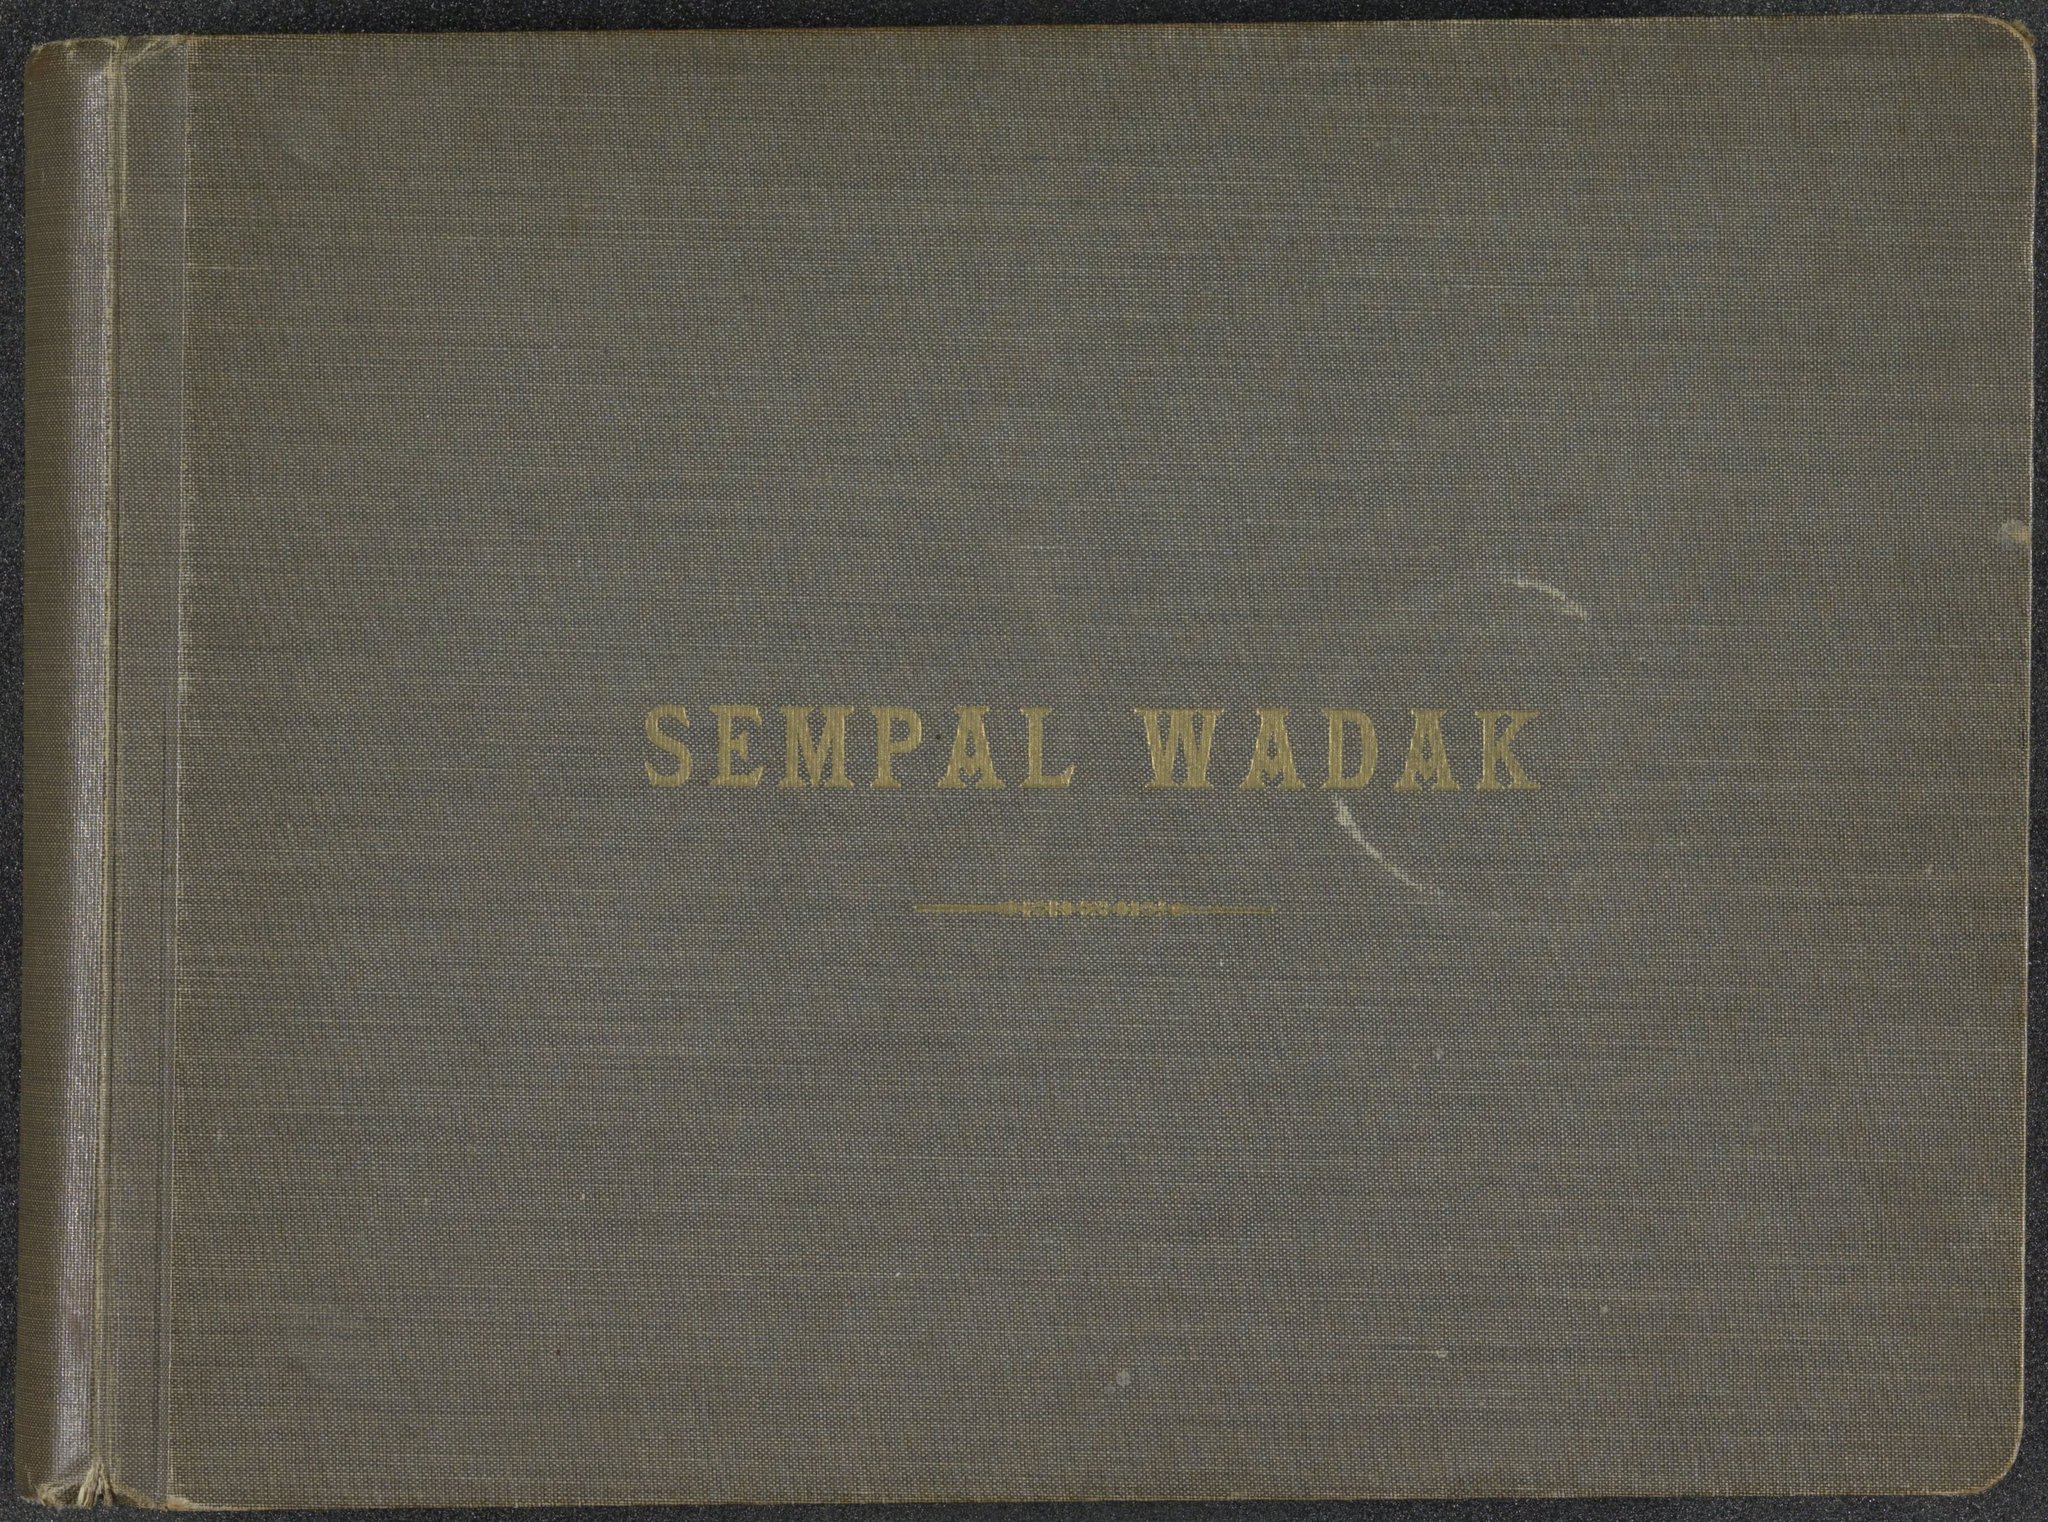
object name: scrapbook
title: Fotoalbum met opnames van de bouw van een brug over de Kali Brantas ten zuiden van Malang op Java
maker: Anonymous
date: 1890-1920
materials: cardboard, ink, linen, paper, photographic support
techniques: gelatin silver print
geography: dutch east indies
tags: engineering, landscape with bridge, viaduct or aqueduct, bridge, building-site, java, dutch east indies, the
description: Fotoalbum in bruingroene linnen band met op het voorplat in gouddruk 'Sempal Wadak'. De schutbladen hebben een geometrisch motief in wit en groen. Het album bevat 30 kartonnen bladen met 23 foto's. Het zijn opnames van de bouw van een brug over de Kali Brantas, een rivier ten zuiden van Malang op Oost-Java. Alle bouwfases zijn in beeld gebracht: van het bouwrijp maken van het emplacement, de aanleg van landhoofden, de plaatsing van de brugpijlers tot en met de voltooiing van de overspanning. Tegenover elke afdruk is een vel papier geplakt met daarop een met pen geschreven - vaak uitgebreid en technisch - bijschrift. De fotograaf en de samensteller zijn onbekend; in de bijschriften worden genoemd 'de Heer van Leeuwen' en 'J.'